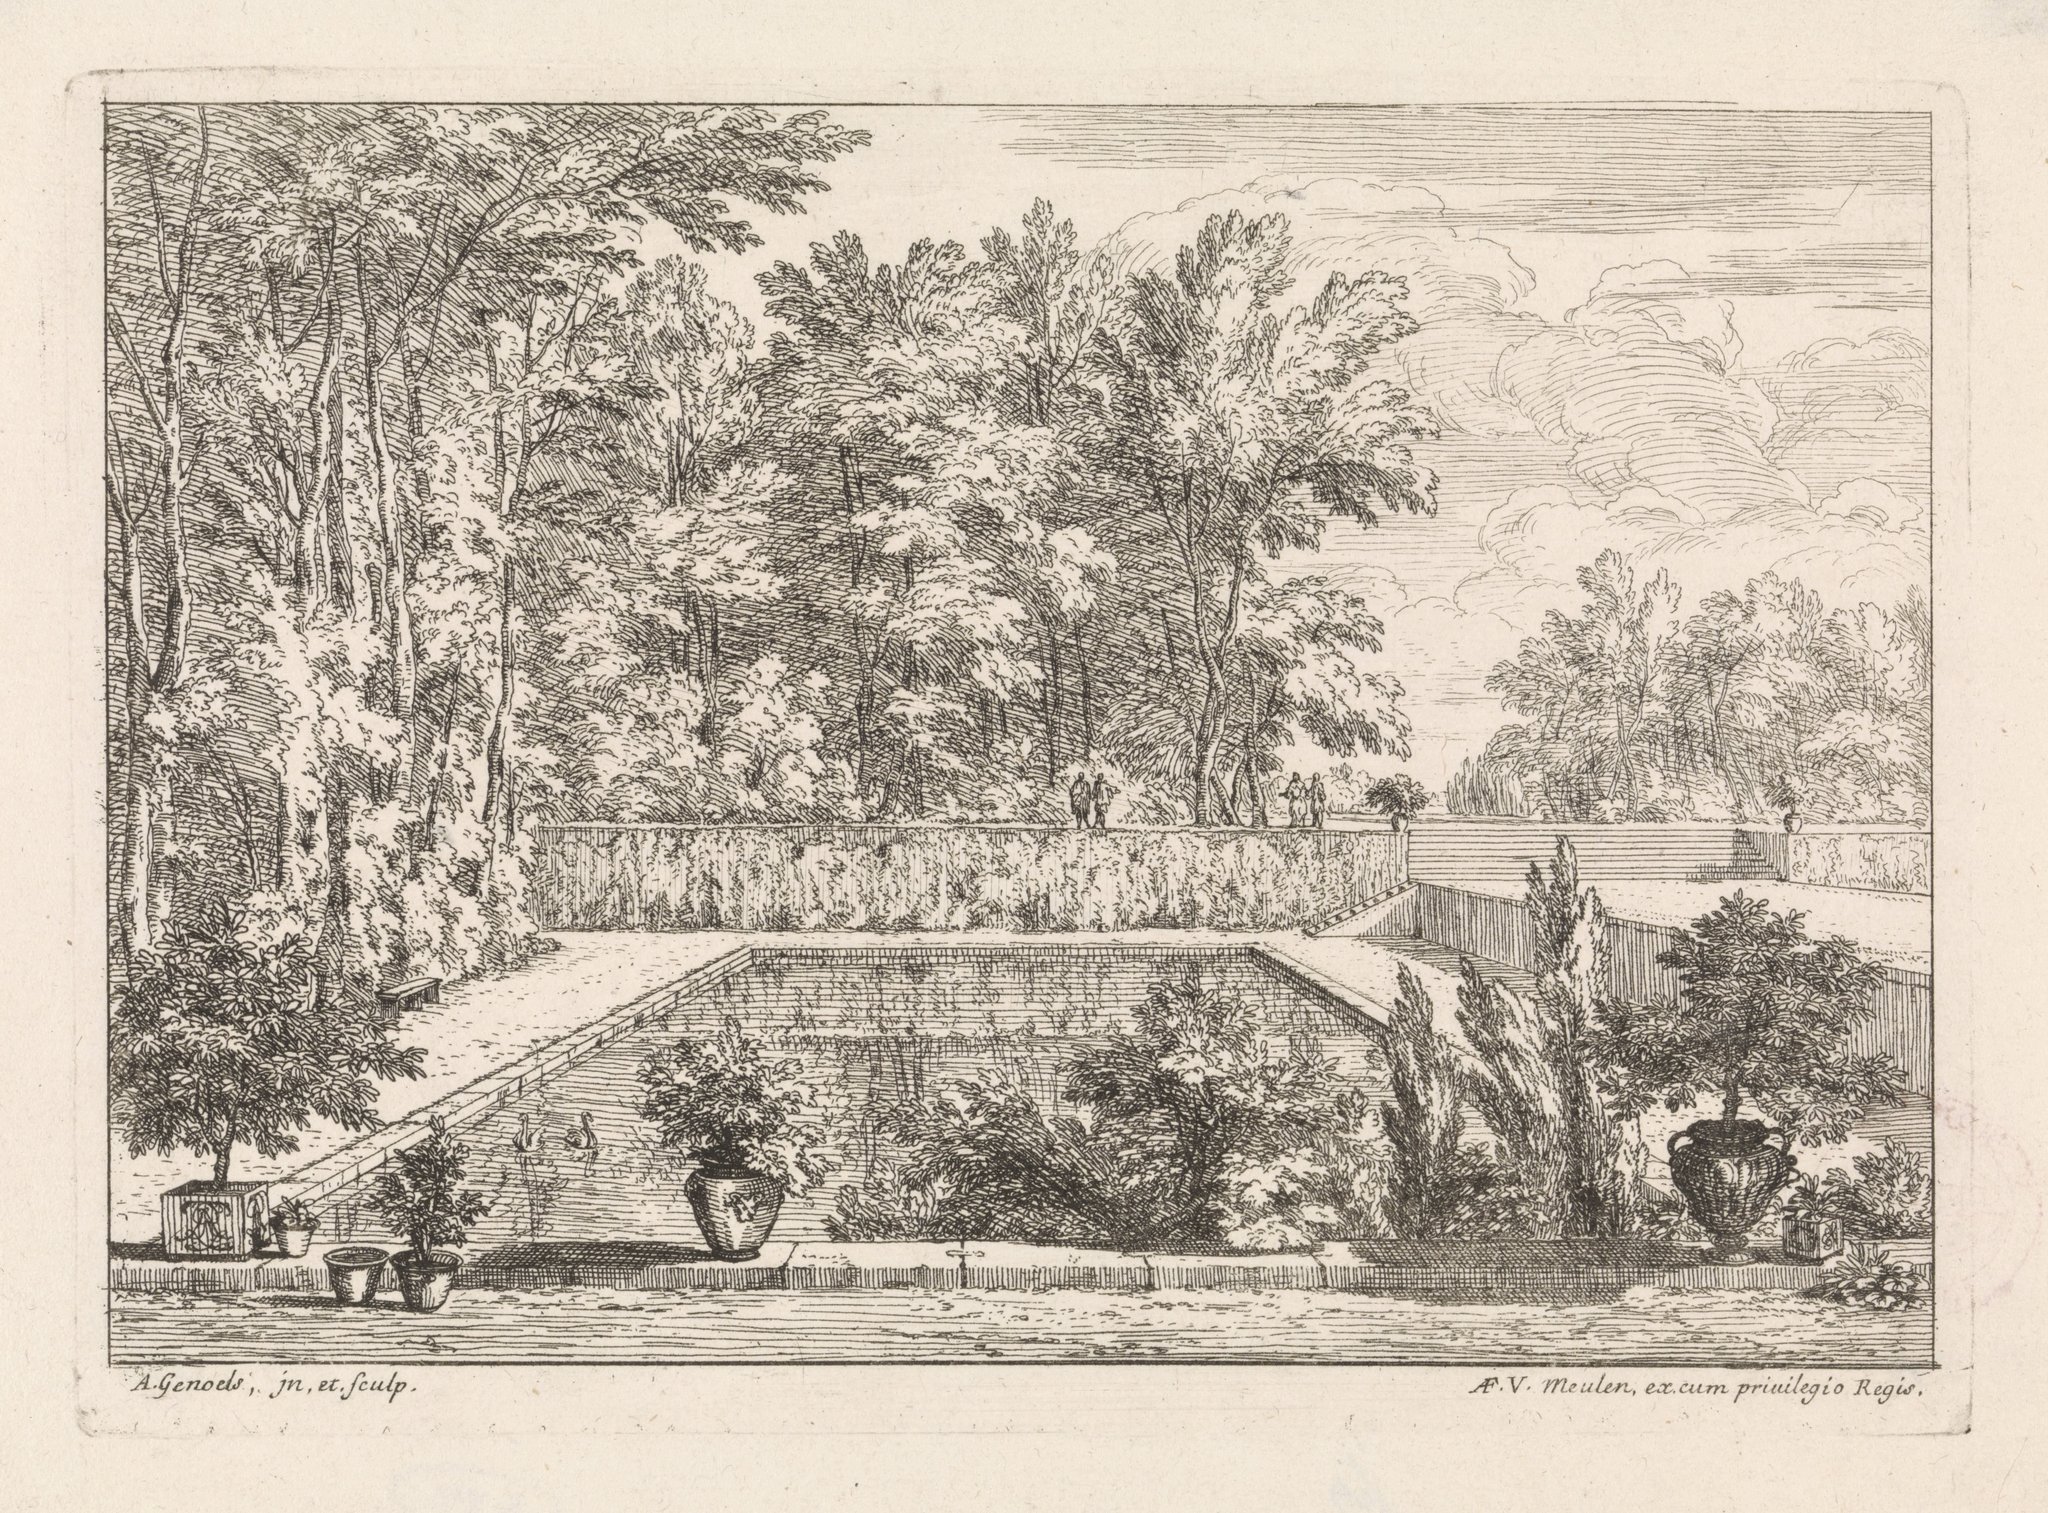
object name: print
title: Architectonische tuinen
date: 1650-1690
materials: paper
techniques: etching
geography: paris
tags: water-birds: swan, french or architectonic garden; formal garden, garden pond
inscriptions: collector's mark: Lugt 240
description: Een bassin in een architectonische tuin. De prent maakt deel uit van een serie met zes tuinlandschappen.